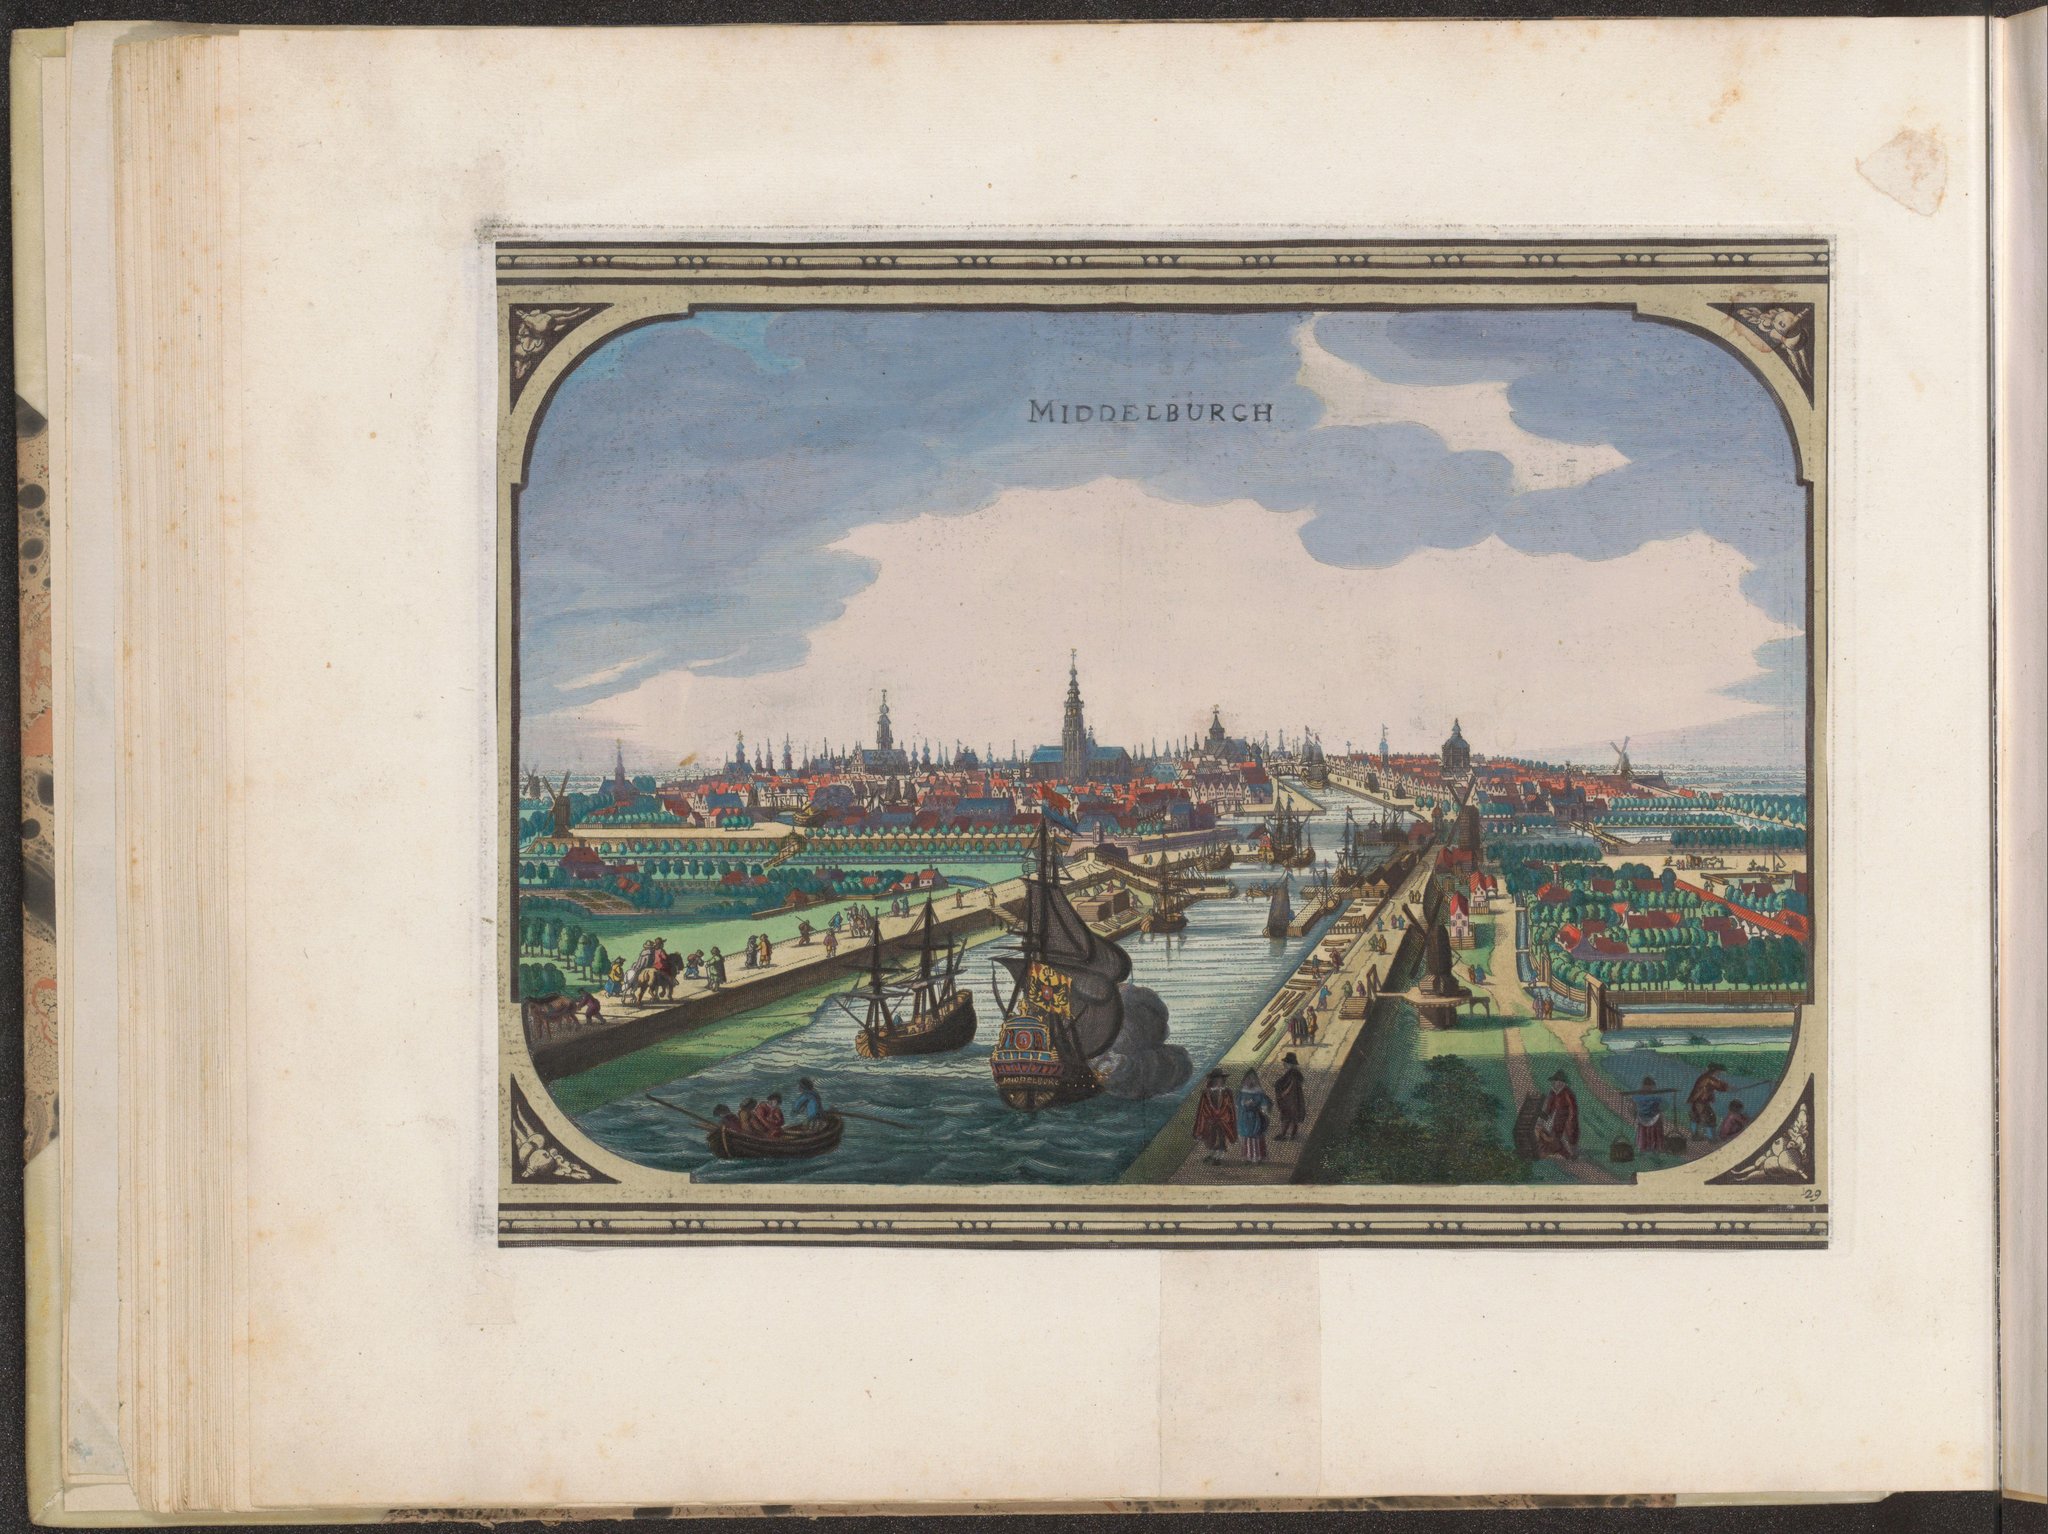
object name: print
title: Gezicht op Middelburg, vanaf de vaart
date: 1662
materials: paper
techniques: etching, hand coloring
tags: city-view, and landscape with man-made constructions, ships (in general), tow-boat, towing-barge, middelburg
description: De prent werd eerder uitgegeven als nummer 29 in het Theatrum praecipuarum. Daarna werd ze opgenomen als nummer 2 in de Speculum Zelandiae.